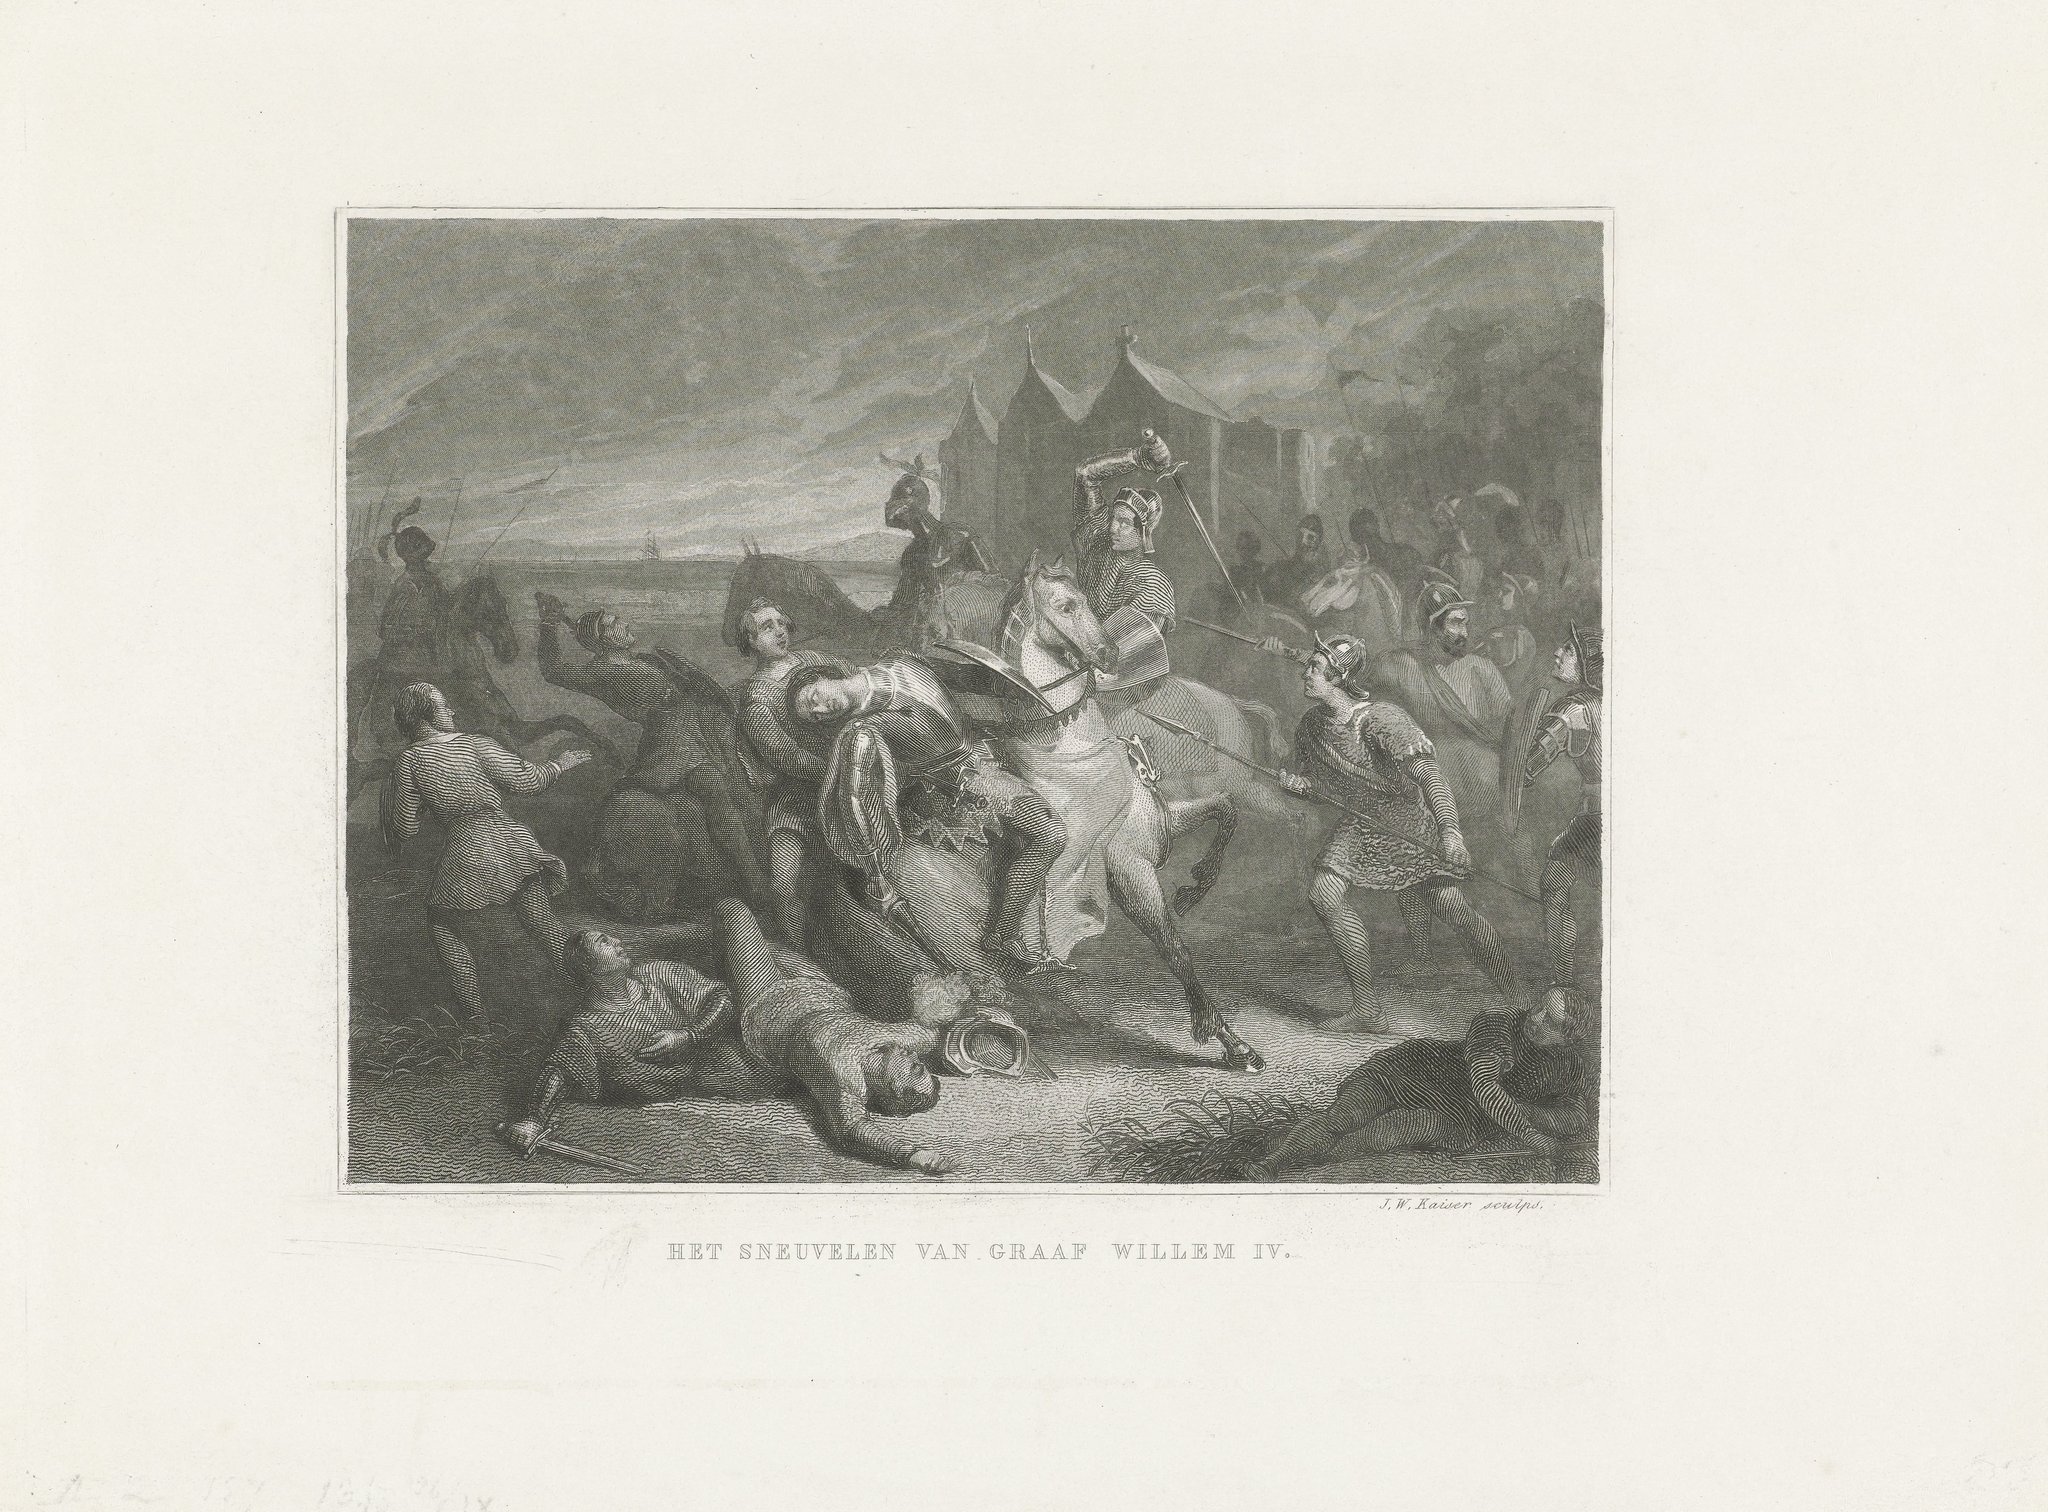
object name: print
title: Het sneuvelen van graaf Willem IV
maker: johann wilhelm kaiser (i)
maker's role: draughtsman, print maker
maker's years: 1813-1900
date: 1840-1884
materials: paper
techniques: etching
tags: willem iv (graaf van holland)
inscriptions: collector's mark: Lugt 2228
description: Graaf Willem IV van Holland en Henegouwen wordt door de Friezen gedood in een hinderlaag bij Stavoren, 26 september 1345. Willem IV is door een pijl in zijn nek geraakt en valt van zijn paard, terwijl zijn krijgsmannen door de Friezen worden aangevallen en weggedreven.